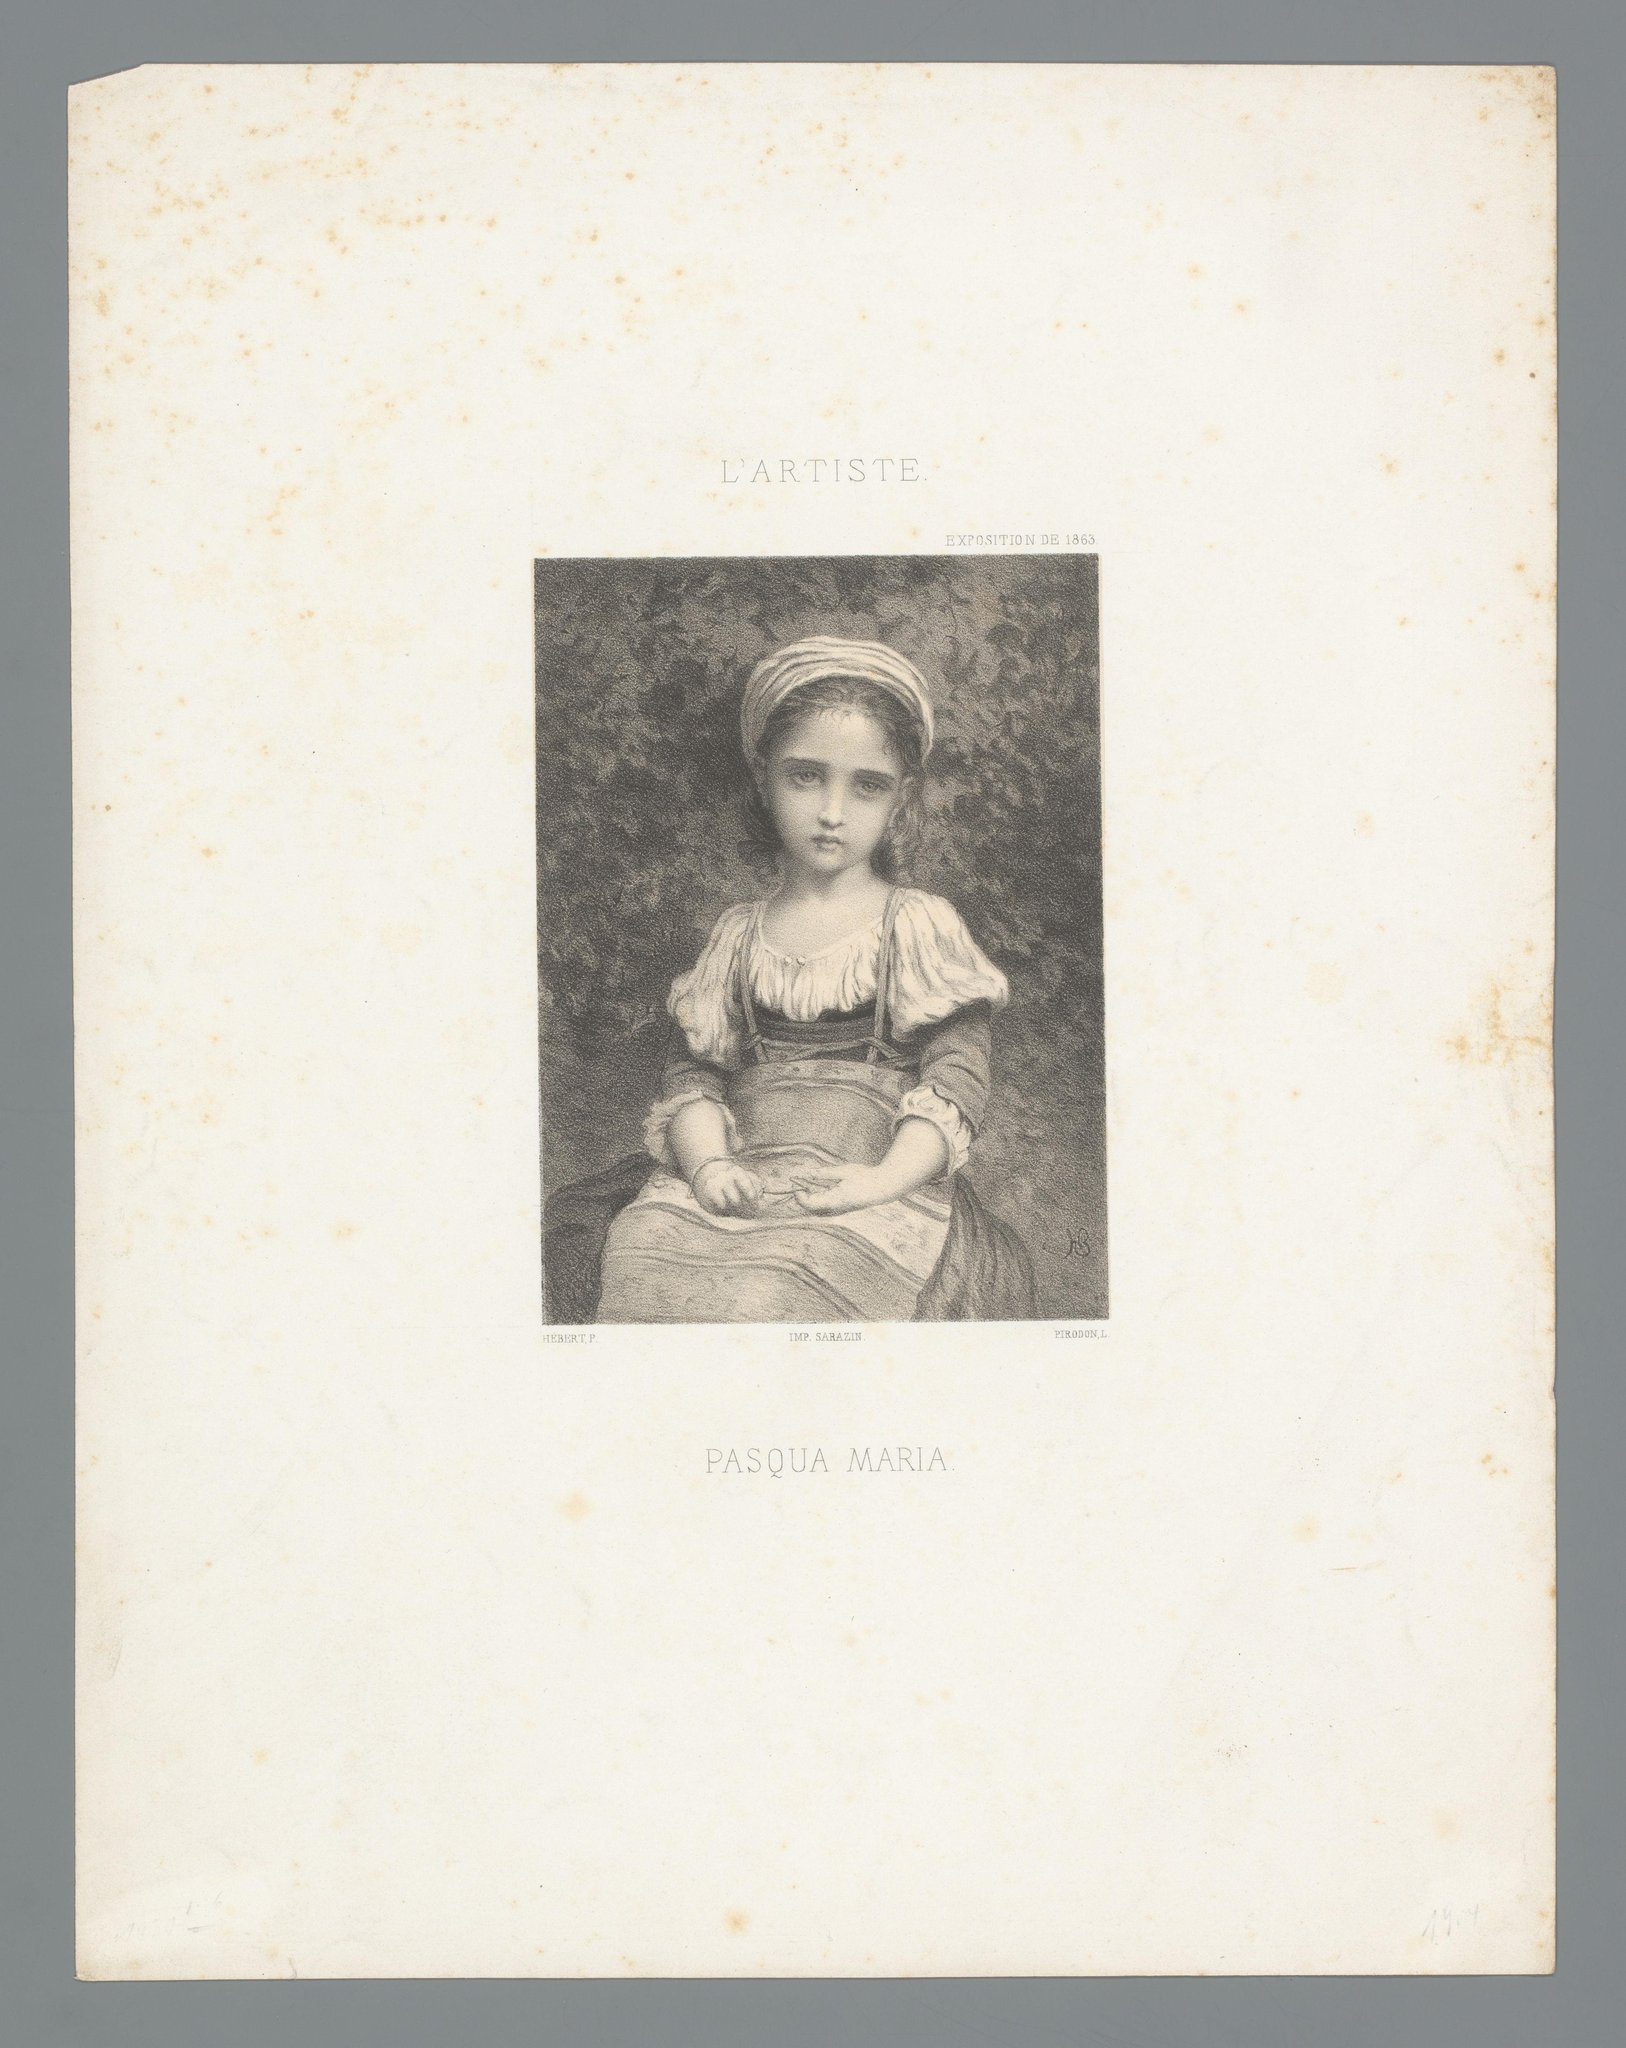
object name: print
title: Pasqua Maria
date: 1863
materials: paper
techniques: lithograph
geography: paris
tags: historical persons, girl (child between toddler and youth)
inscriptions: collector's mark: Lugt 2228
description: Prent gebruikt in: L'Artiste, 1863, dl. 1. Schilderij tentoongesteld op de Salon van 1863 in Parijs.